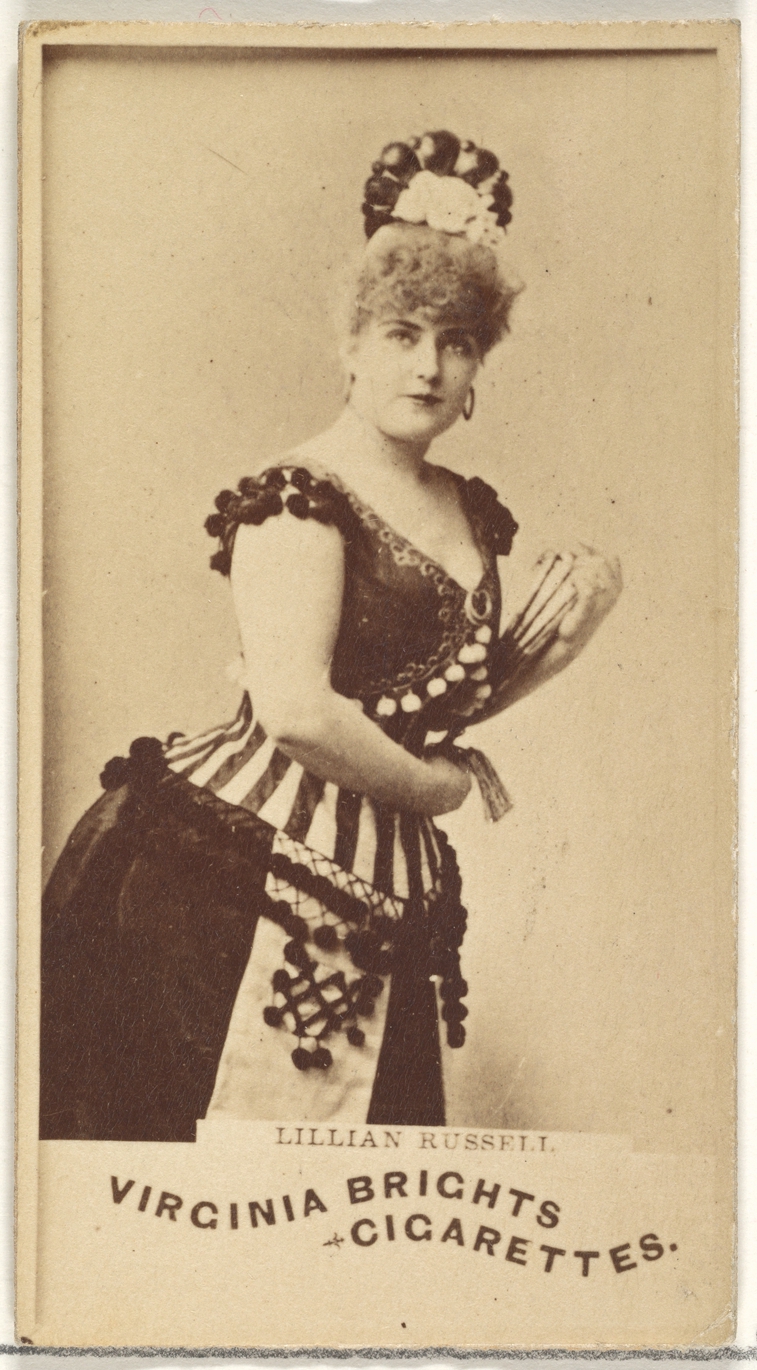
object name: photograph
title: Lillian Russell, from the Actors and Actresses series (N45, Type 1) for Virginia Brights Cigarettes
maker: allen & ginter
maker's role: publisher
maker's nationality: american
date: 1888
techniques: albumen silver print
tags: portraits,women,actresses